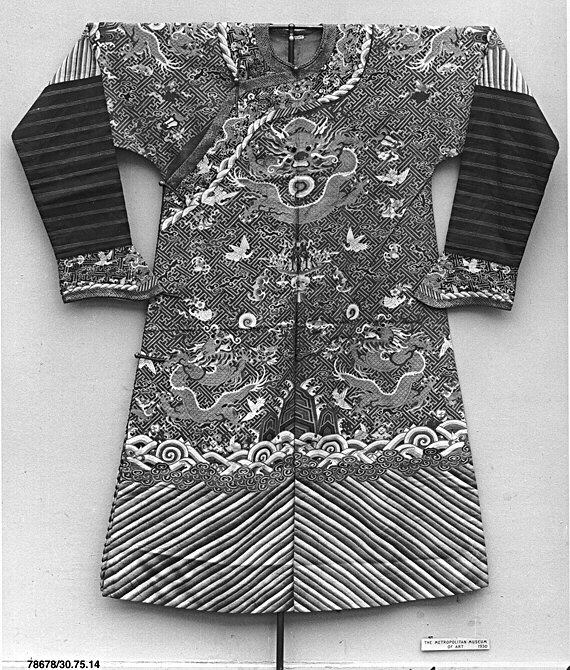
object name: robe, imperial court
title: Imperial Court Robe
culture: chinese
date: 1875-1908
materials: metal thread, silk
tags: dragons